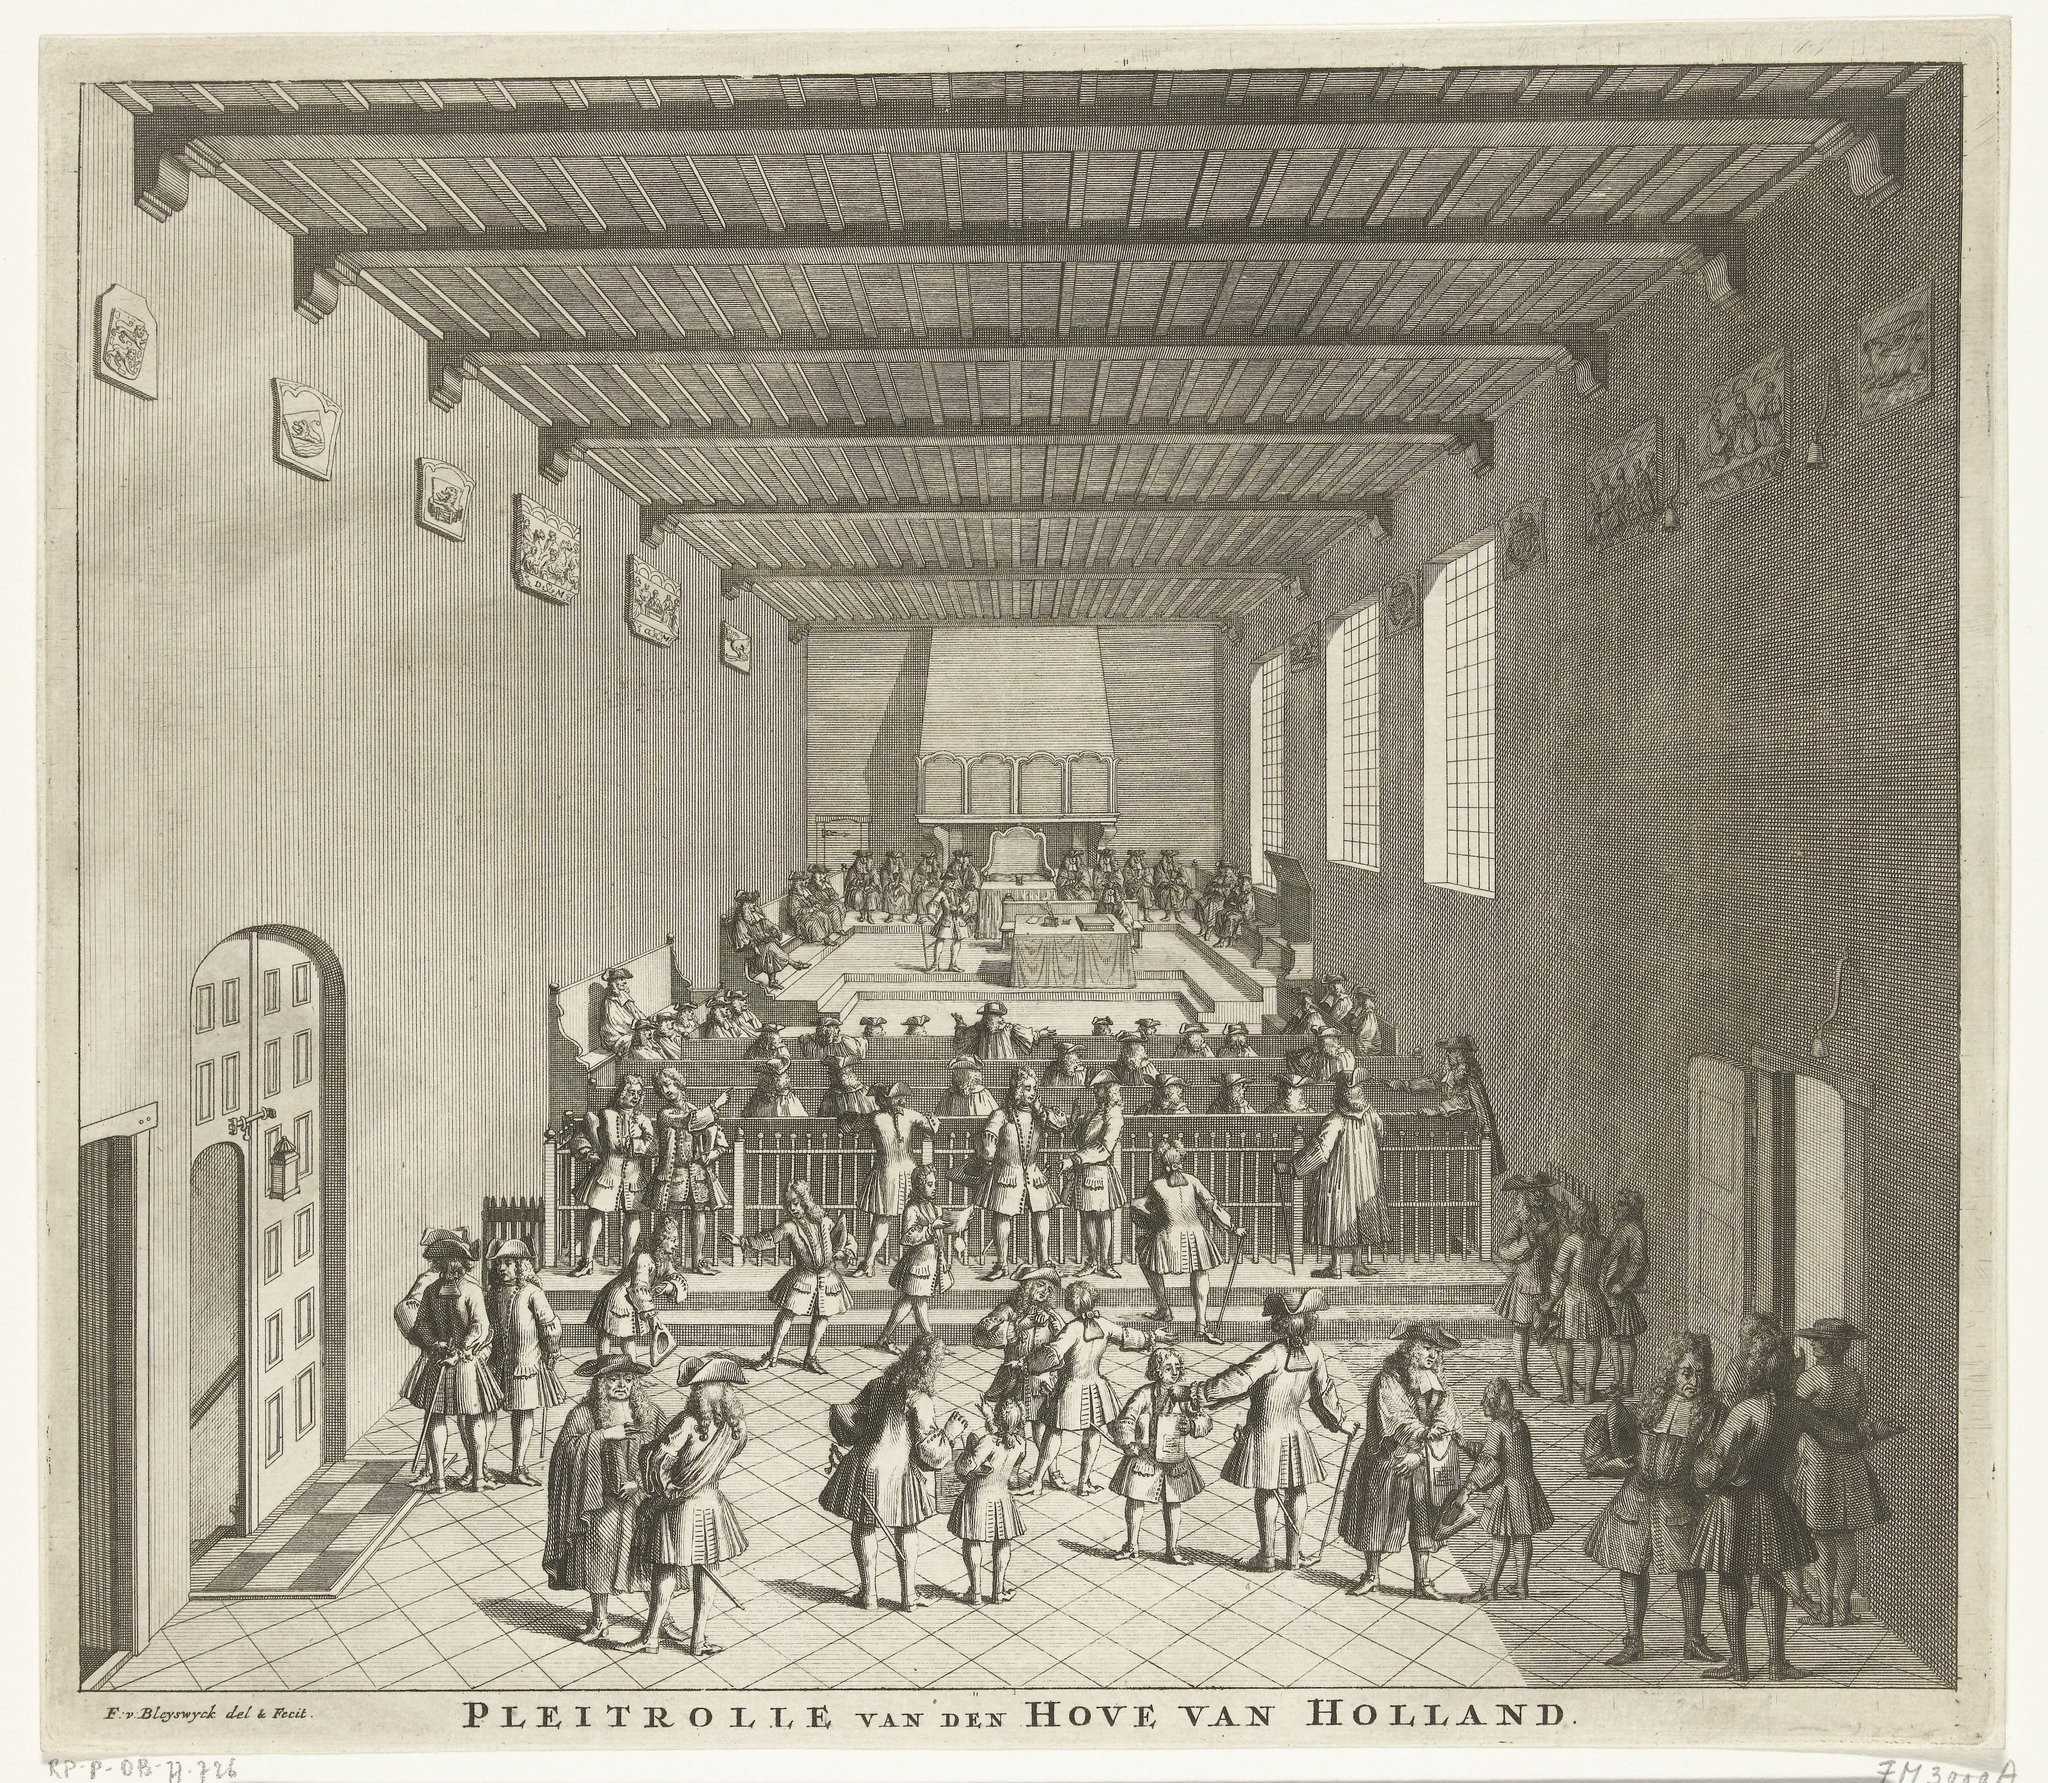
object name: print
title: Pleitrolle van den Hove van Holland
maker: françois van bleyswijck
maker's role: draughtsman, print maker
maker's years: 1671-1746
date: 1700-1736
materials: paper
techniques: engraving, etching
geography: the hague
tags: court session (court of justice)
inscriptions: signature: ‘F.v. Bleysweyck del & Fecit’, title: ‘Pleitrolle van den Hove van Holland’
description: Gerechtshof van het Hof van Holland in zitting in de Pleitrolle van den Hove Provinciaal (aan de achterzijde van de Ridderzaal). Een advocaat pleit voor het Hof. Advocaten, bedienden en andere heren op de voorgrond.